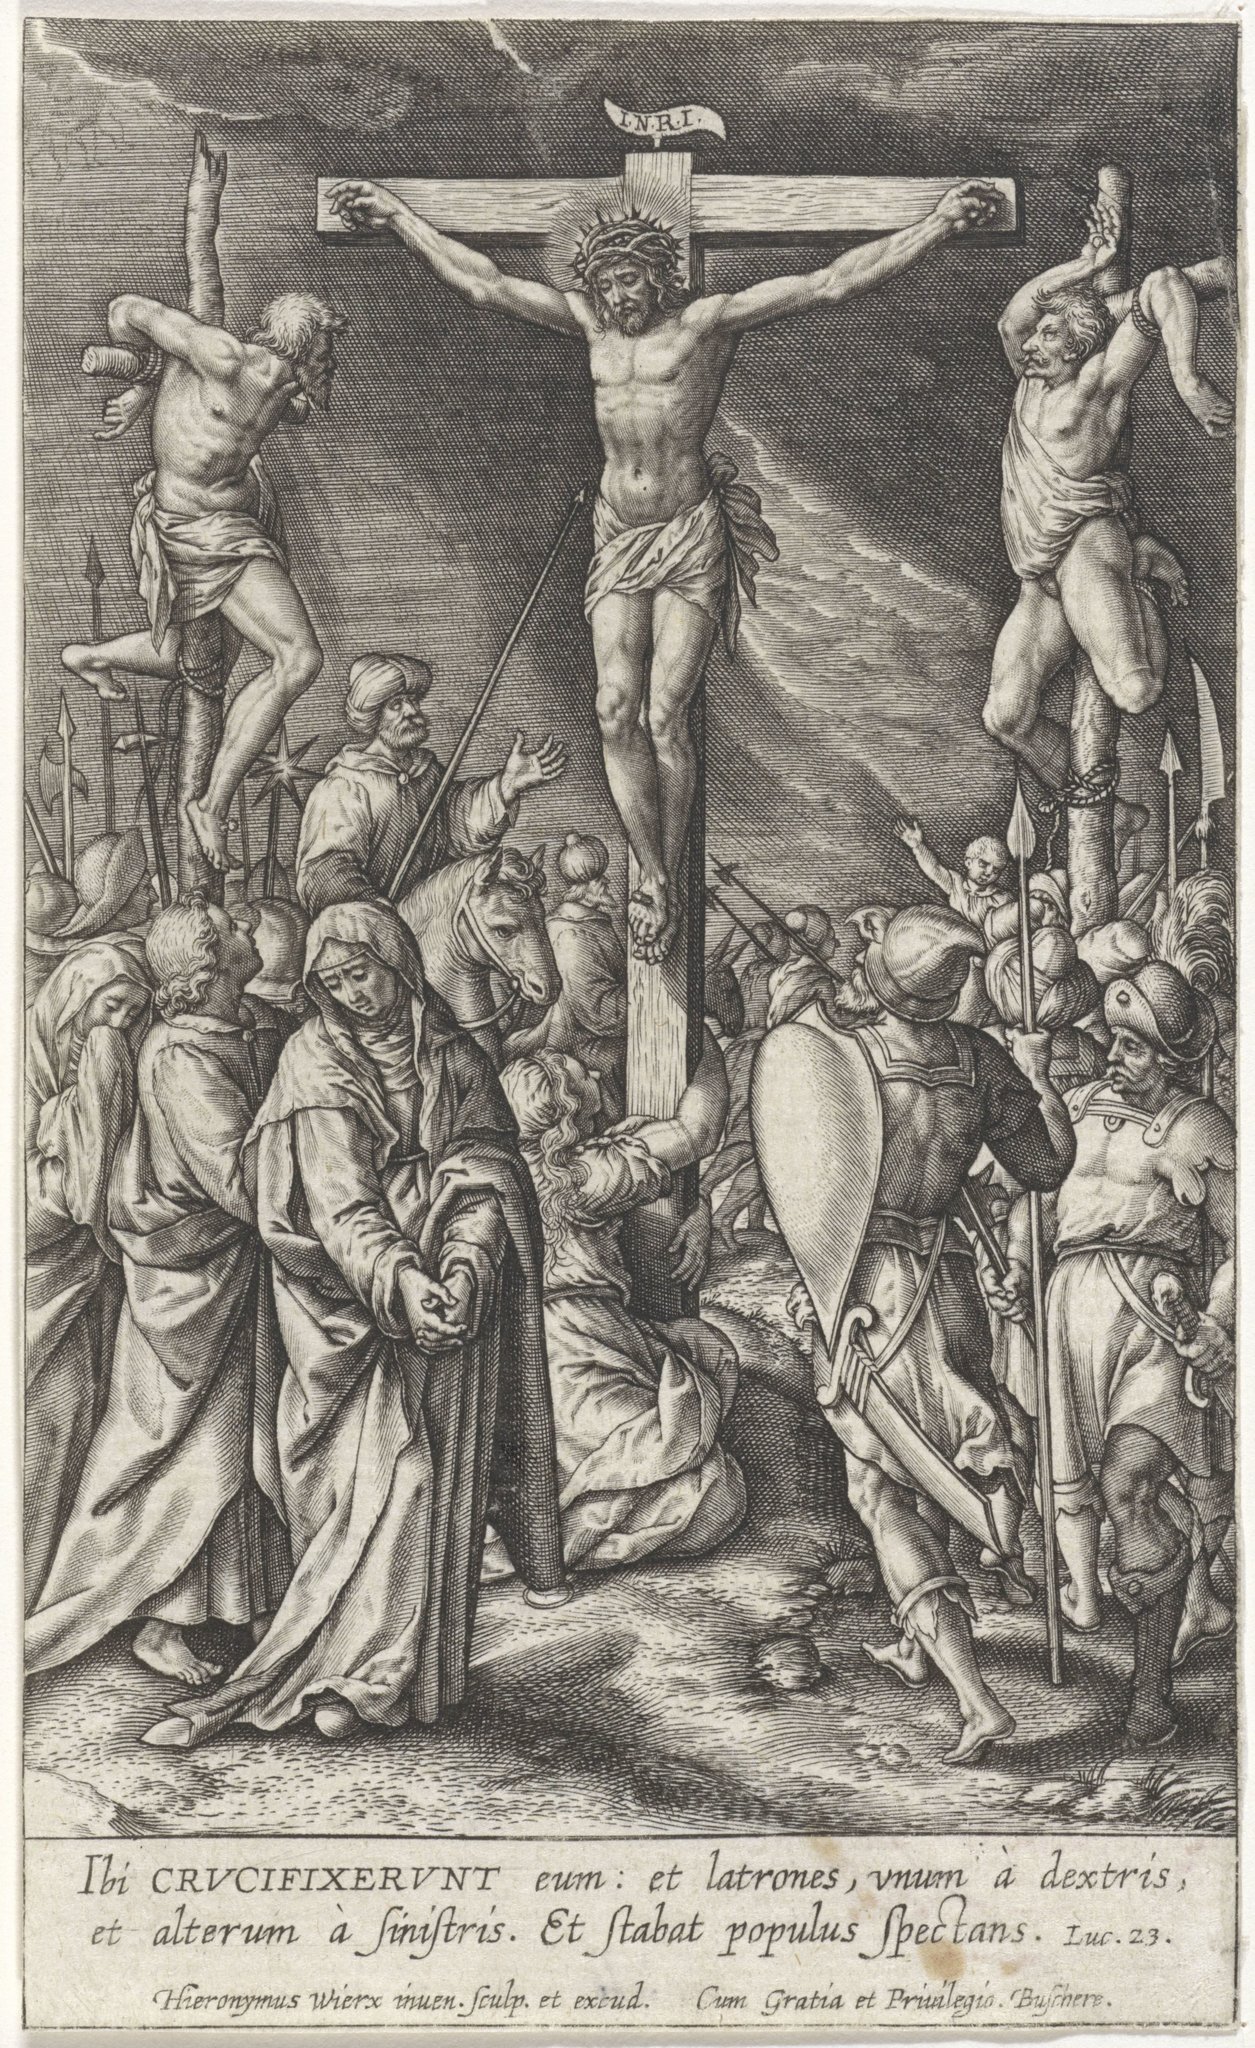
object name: print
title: Kruisiging van Christus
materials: paper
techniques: engraving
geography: antwerp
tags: longinus pierces christ's side with a lance, the crucifixion of christ: christ's death on the cross; golgotha (matthew 27:45-58; mark 15:33-45; luke 23:44-52; john 19:25-38)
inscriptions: collector's mark: Lugt 240, number: ‘34’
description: Kruisdood van Christus op Golgota. Christus hangt aan het kruis, aan weerszijden hangen de samen met Christus gekruisigde misdadigers. Longinus staat op het punt zijn lans in de zijde van Christus te steken. Maria Magdalena treurt aan de voet van het kruis. Op de voorgrond Maria. In de marge een tweeregelig Bijbelcitaat uit Joh. 23 in het Latijn.